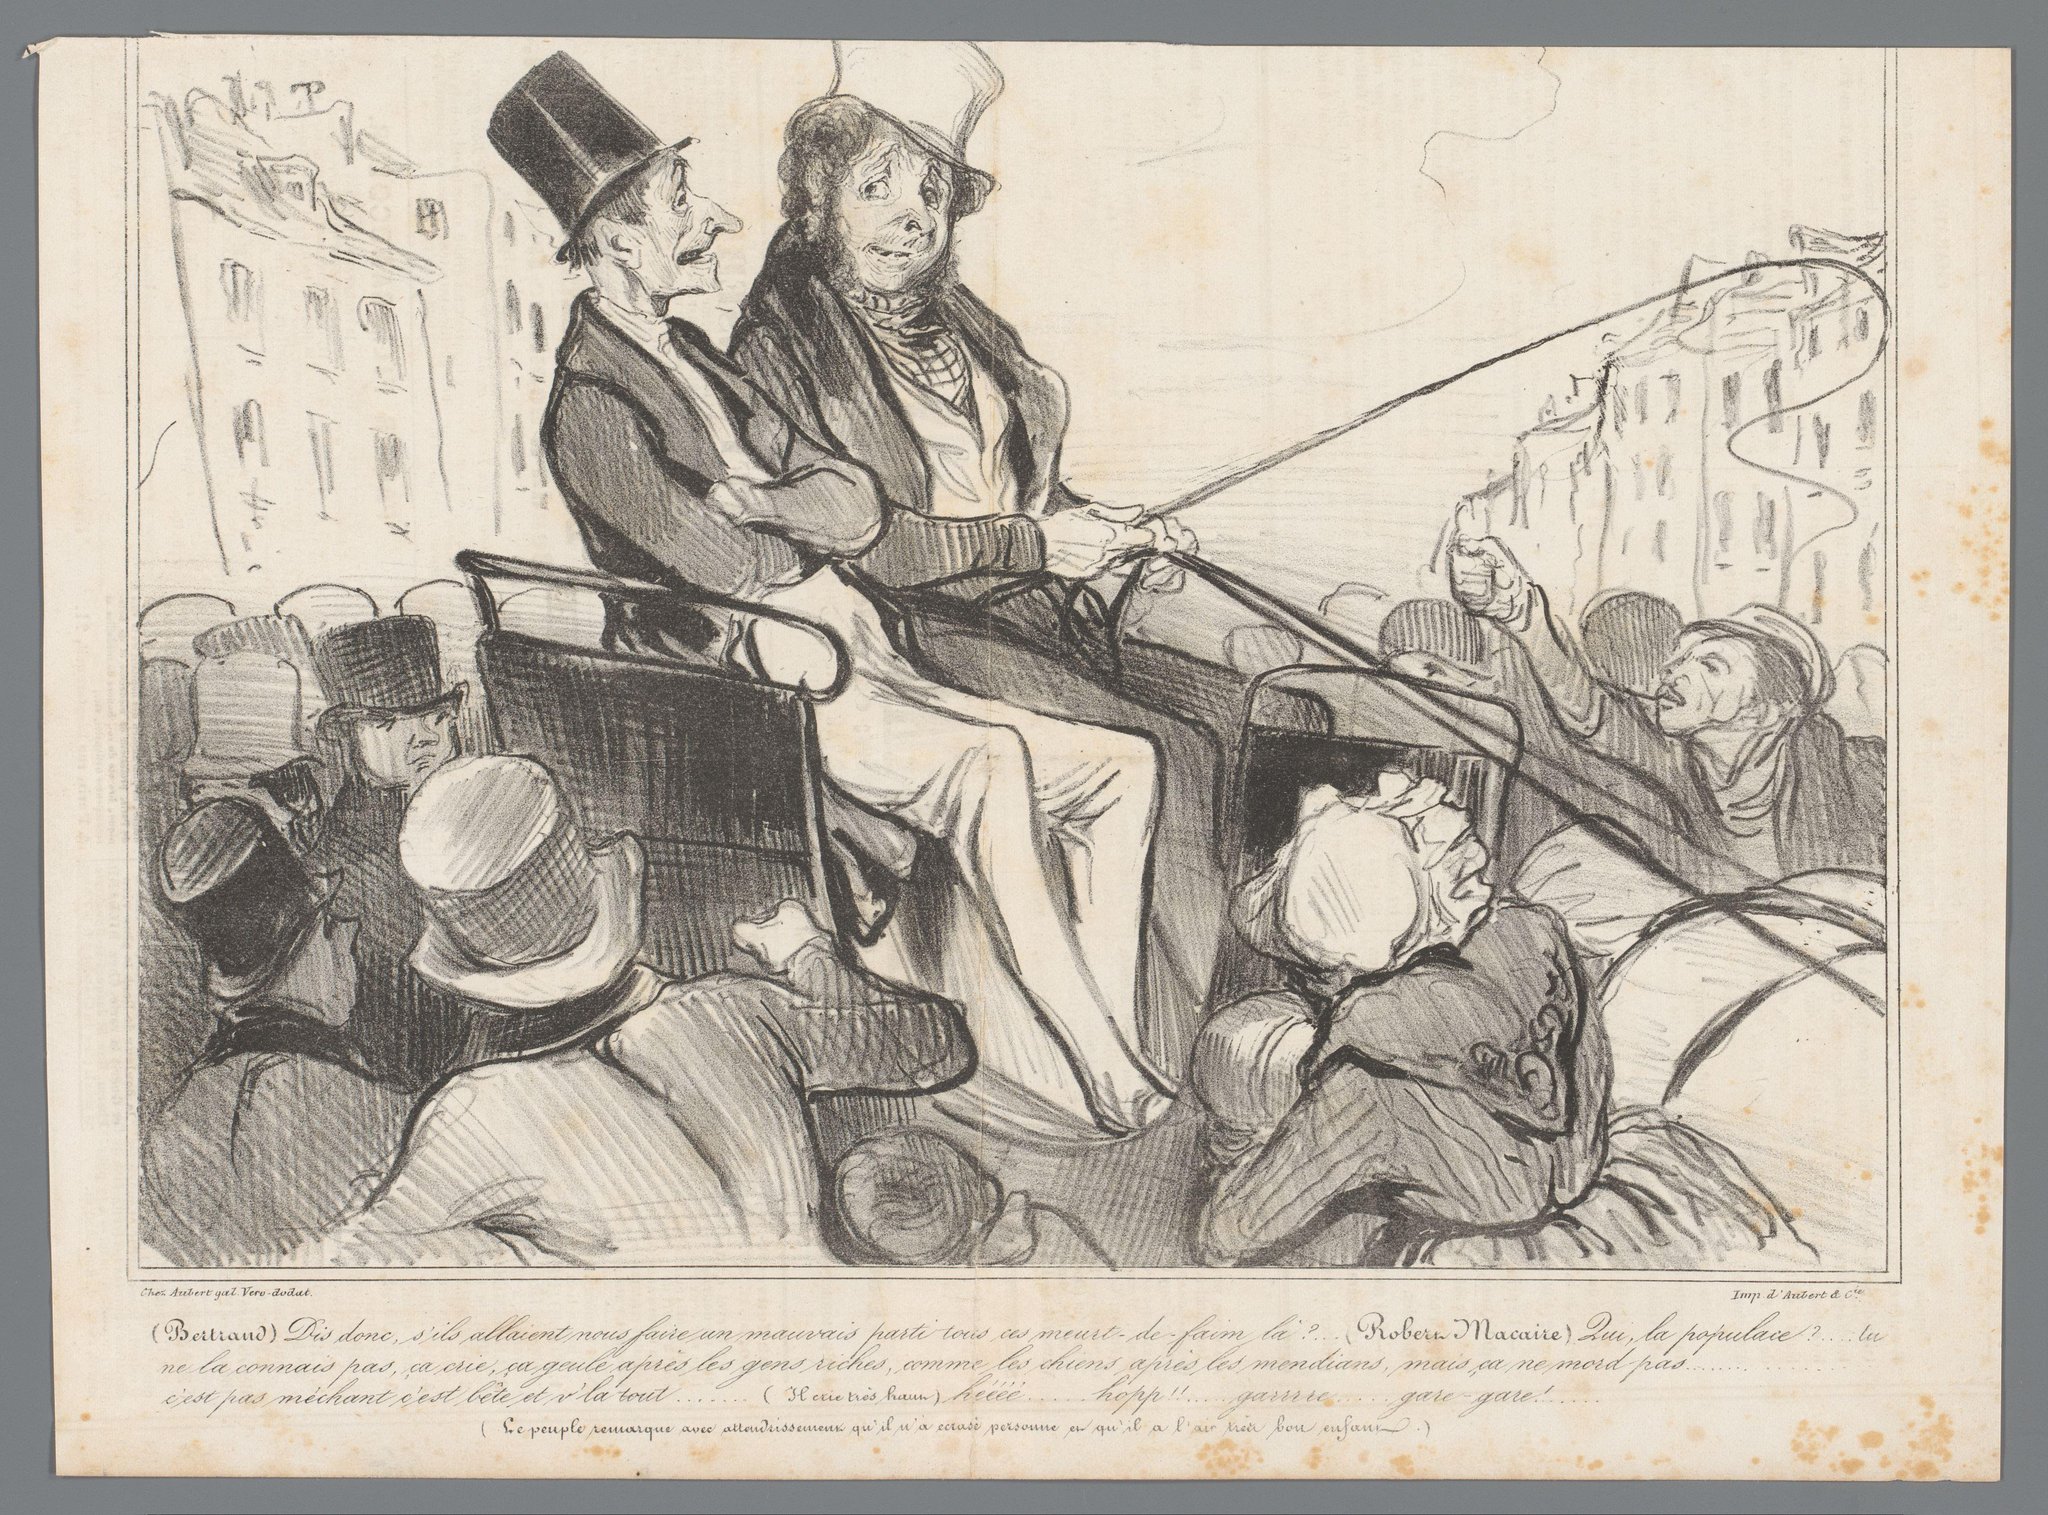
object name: print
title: Caricaturana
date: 1838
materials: paper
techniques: lithograph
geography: paris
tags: animal traction, animal-drawn vehicle (carriage etc.), crowd, mob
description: Prent uit: Le Charivari, 23 september 1838.